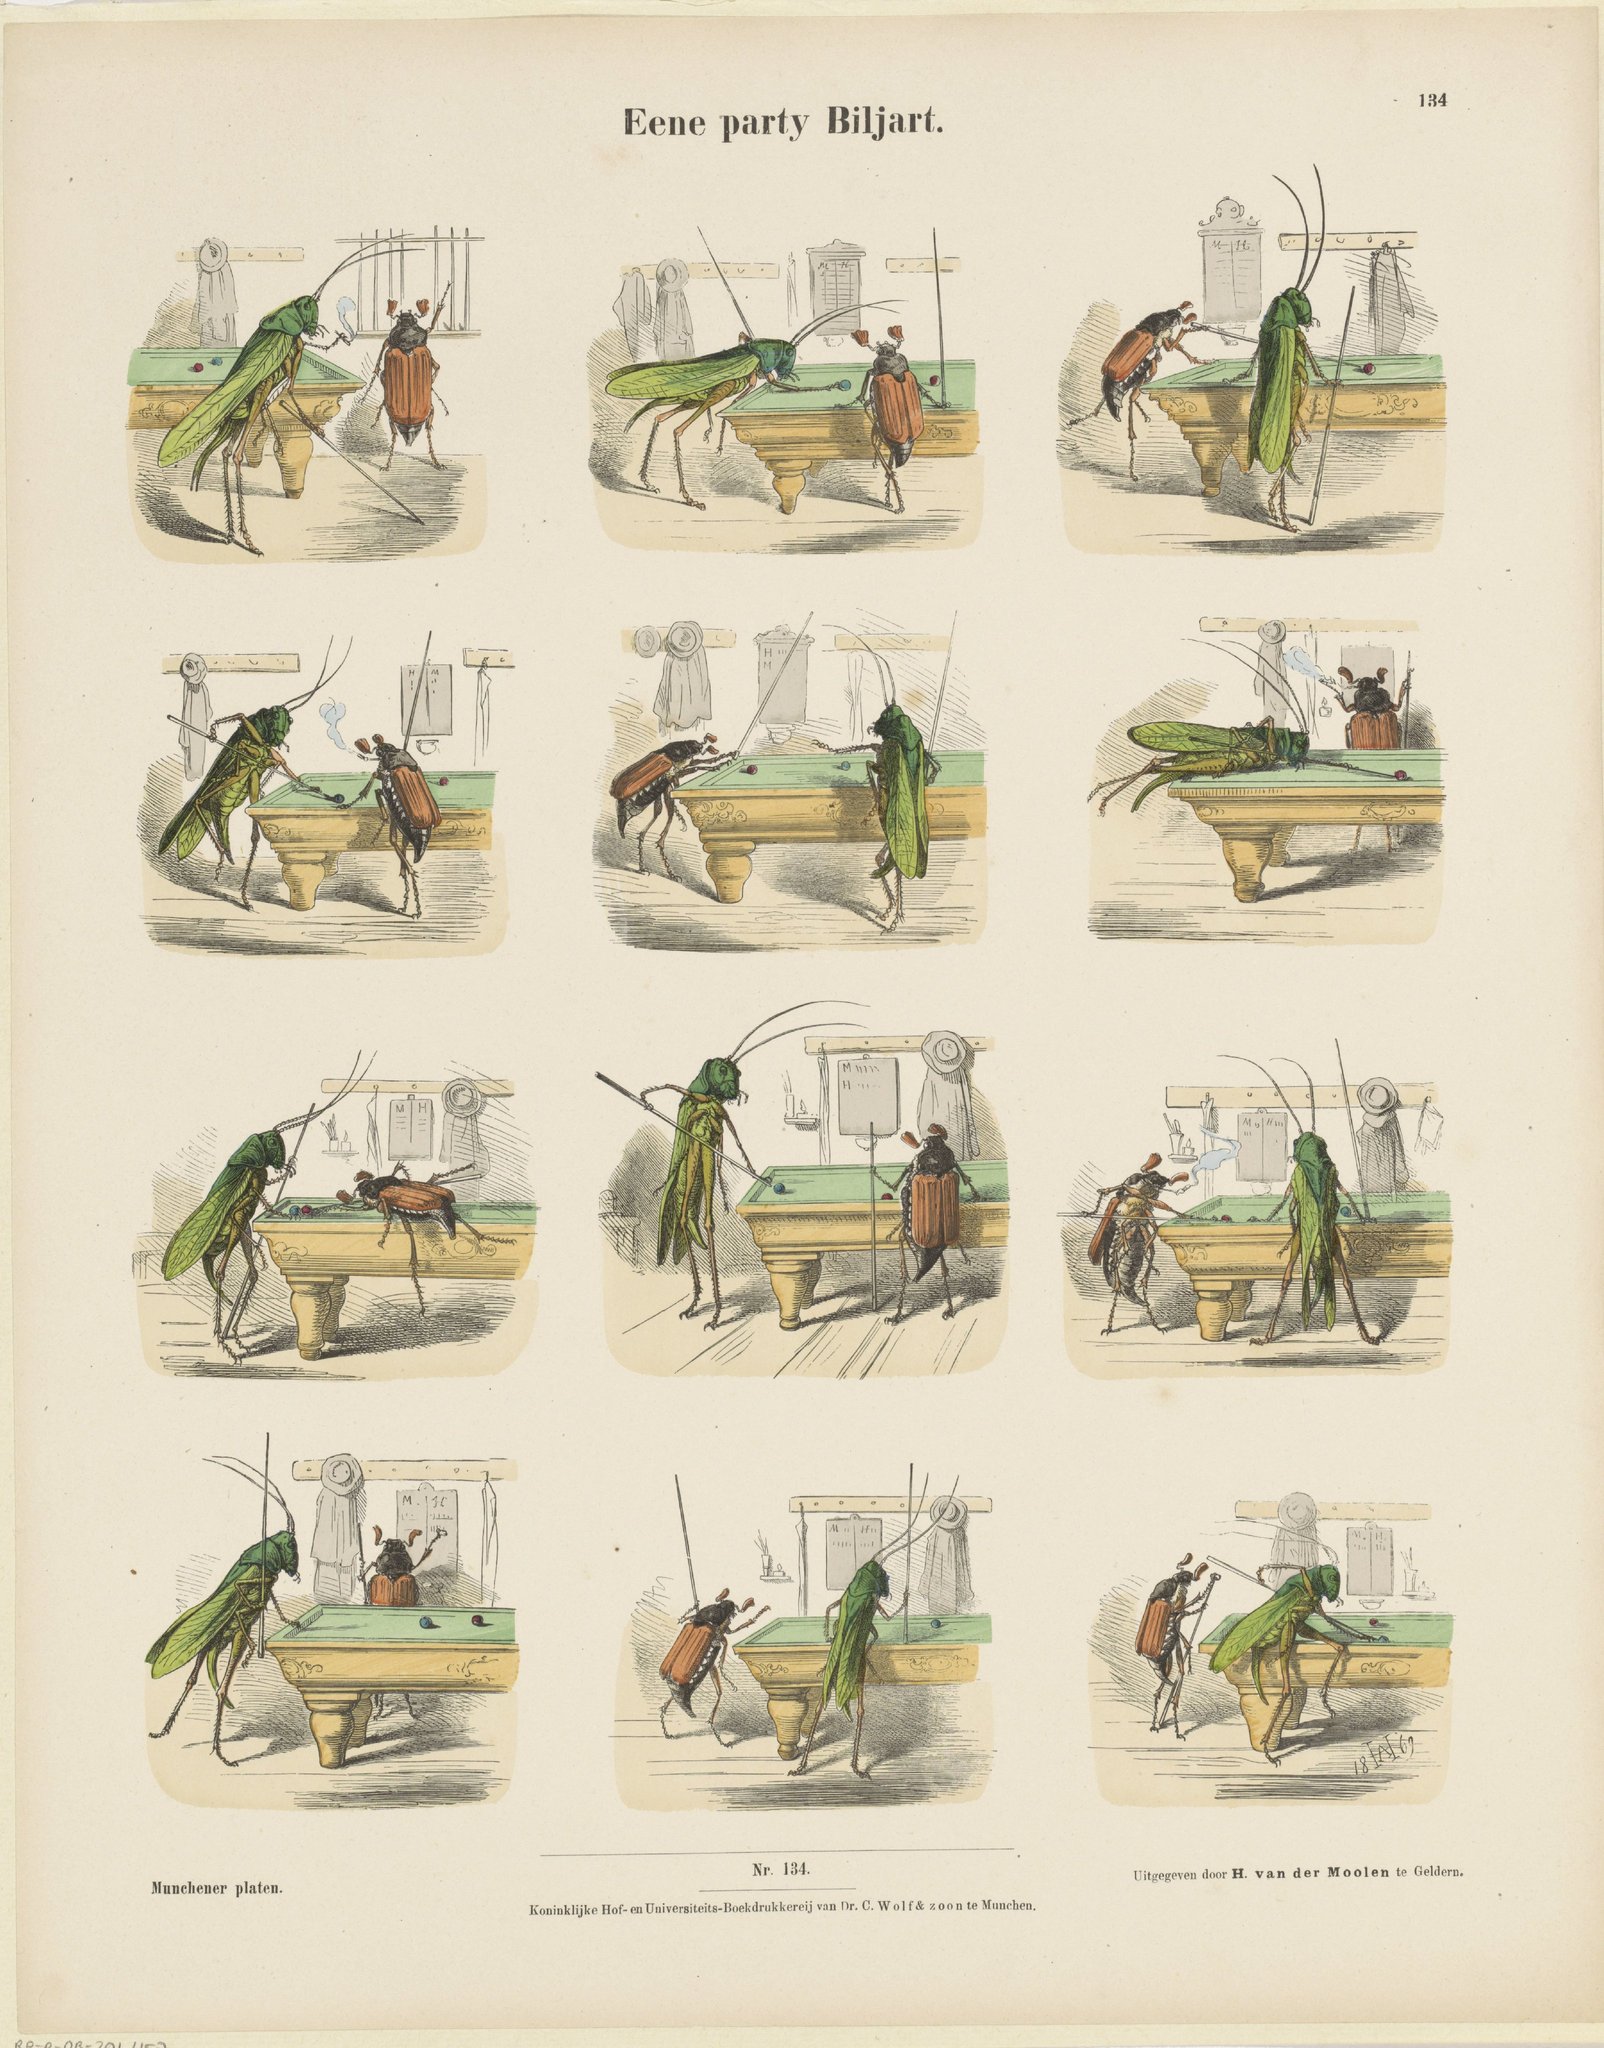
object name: popular print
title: Munchener platen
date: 1869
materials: paper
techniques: colour, letterpress printing, engraving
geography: munich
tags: billiards, animals acting as human beings, insects: grass-hopper, insects: beetle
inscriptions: collector's mark: Lugt 2760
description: Nederlandse editie van een prent uit de reeks "Munchener platen" uitgegeven door K. Braun & Fr. Schneider te München met het adres van wederverkoper Hermann van der Moolen.